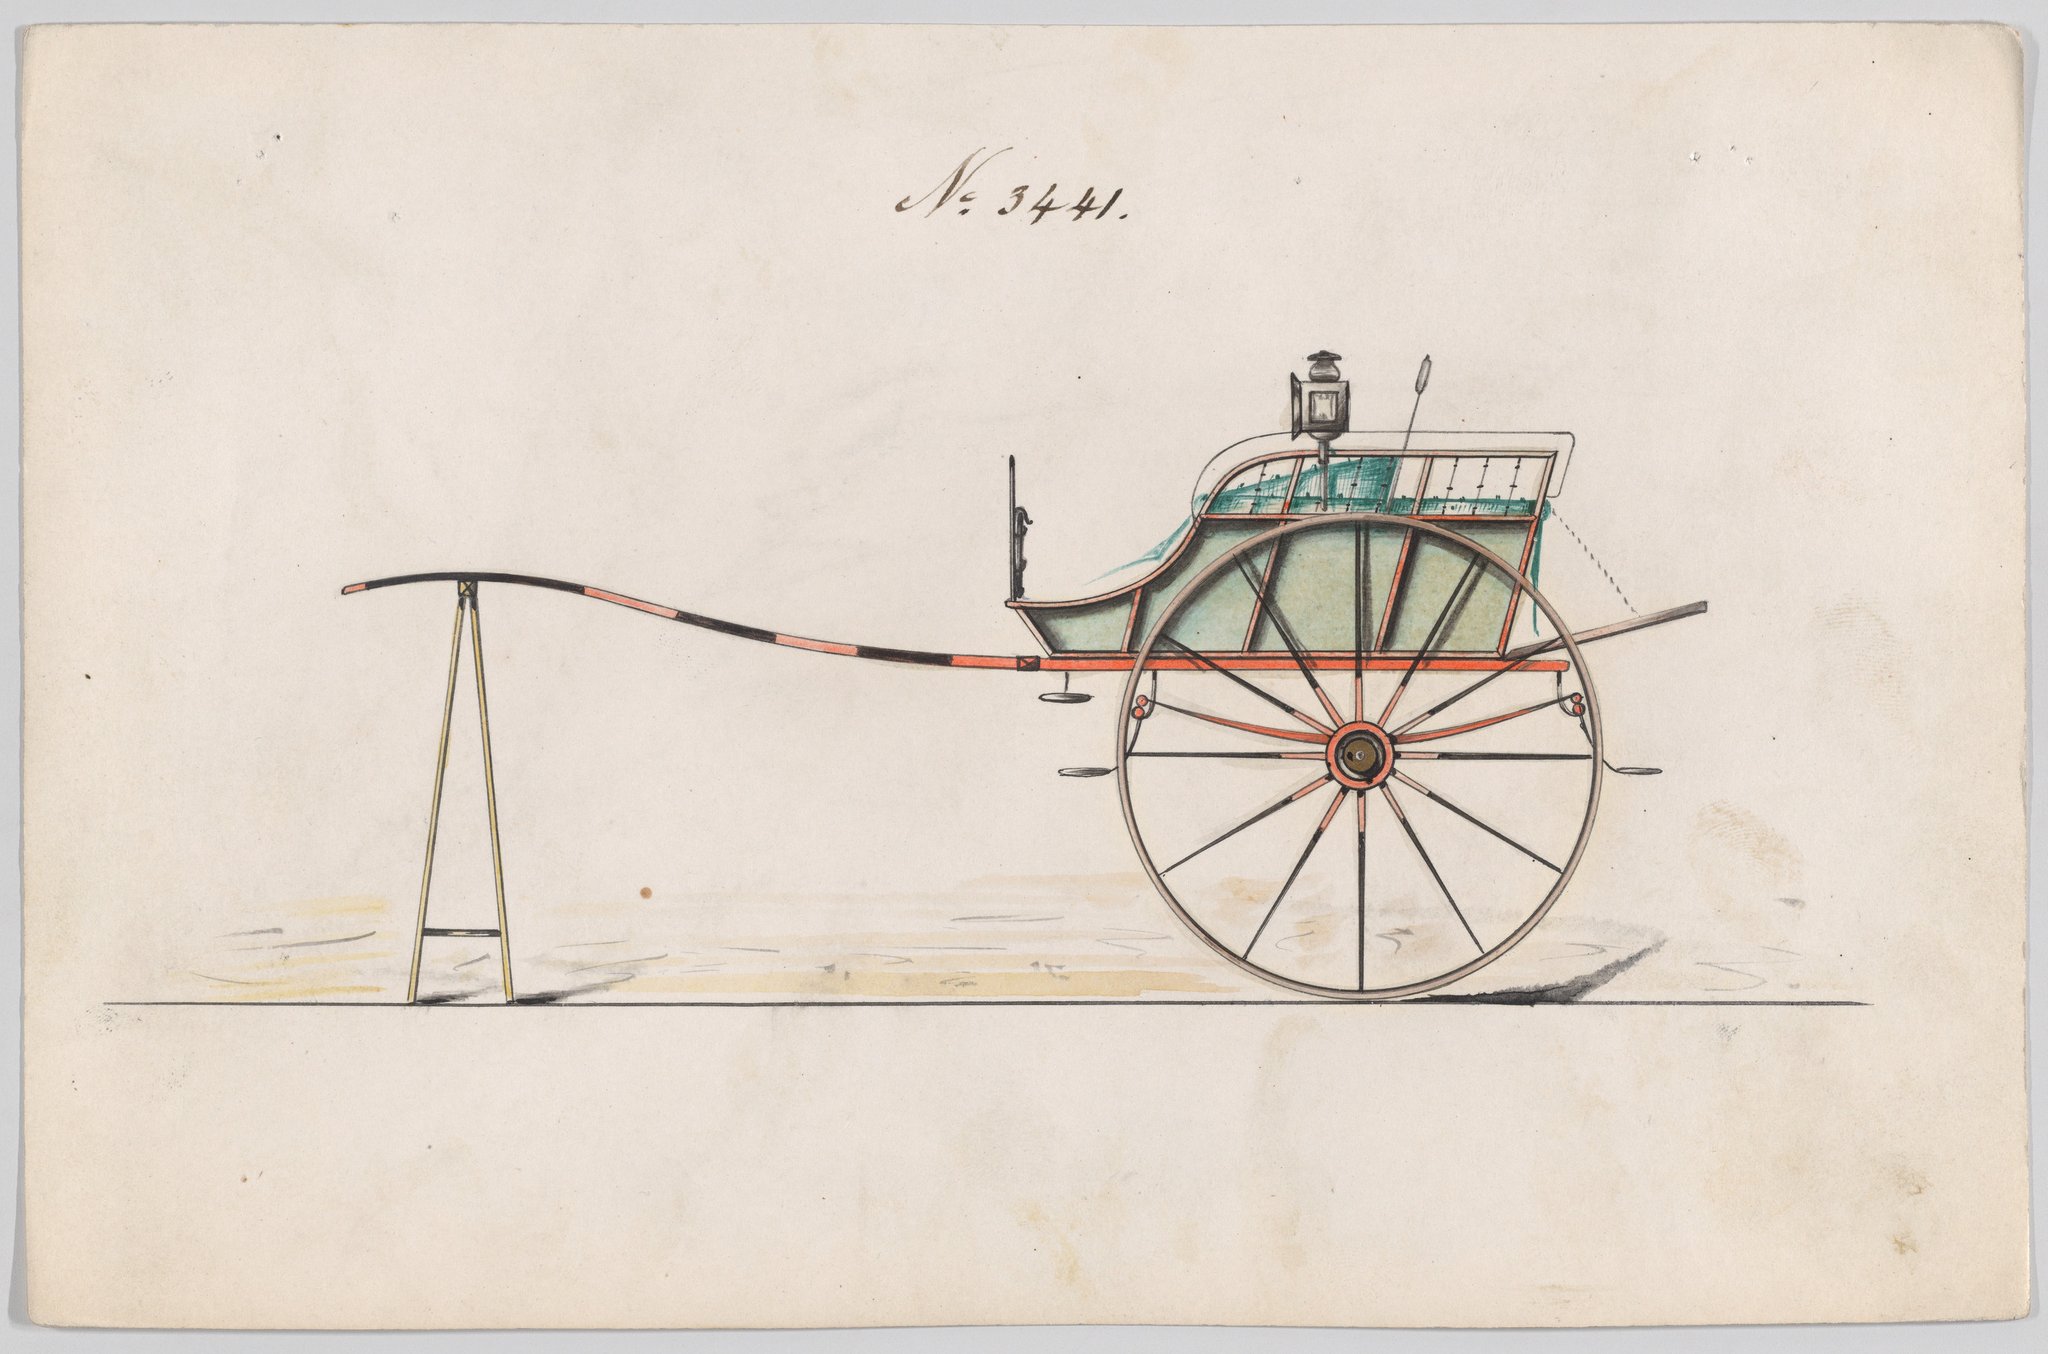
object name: drawing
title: Whitechapel Cart #3441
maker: brewster & co.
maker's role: manufacturer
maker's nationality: american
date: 1878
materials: gouache, gum arabic, ink, watercolor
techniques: pen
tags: carriages